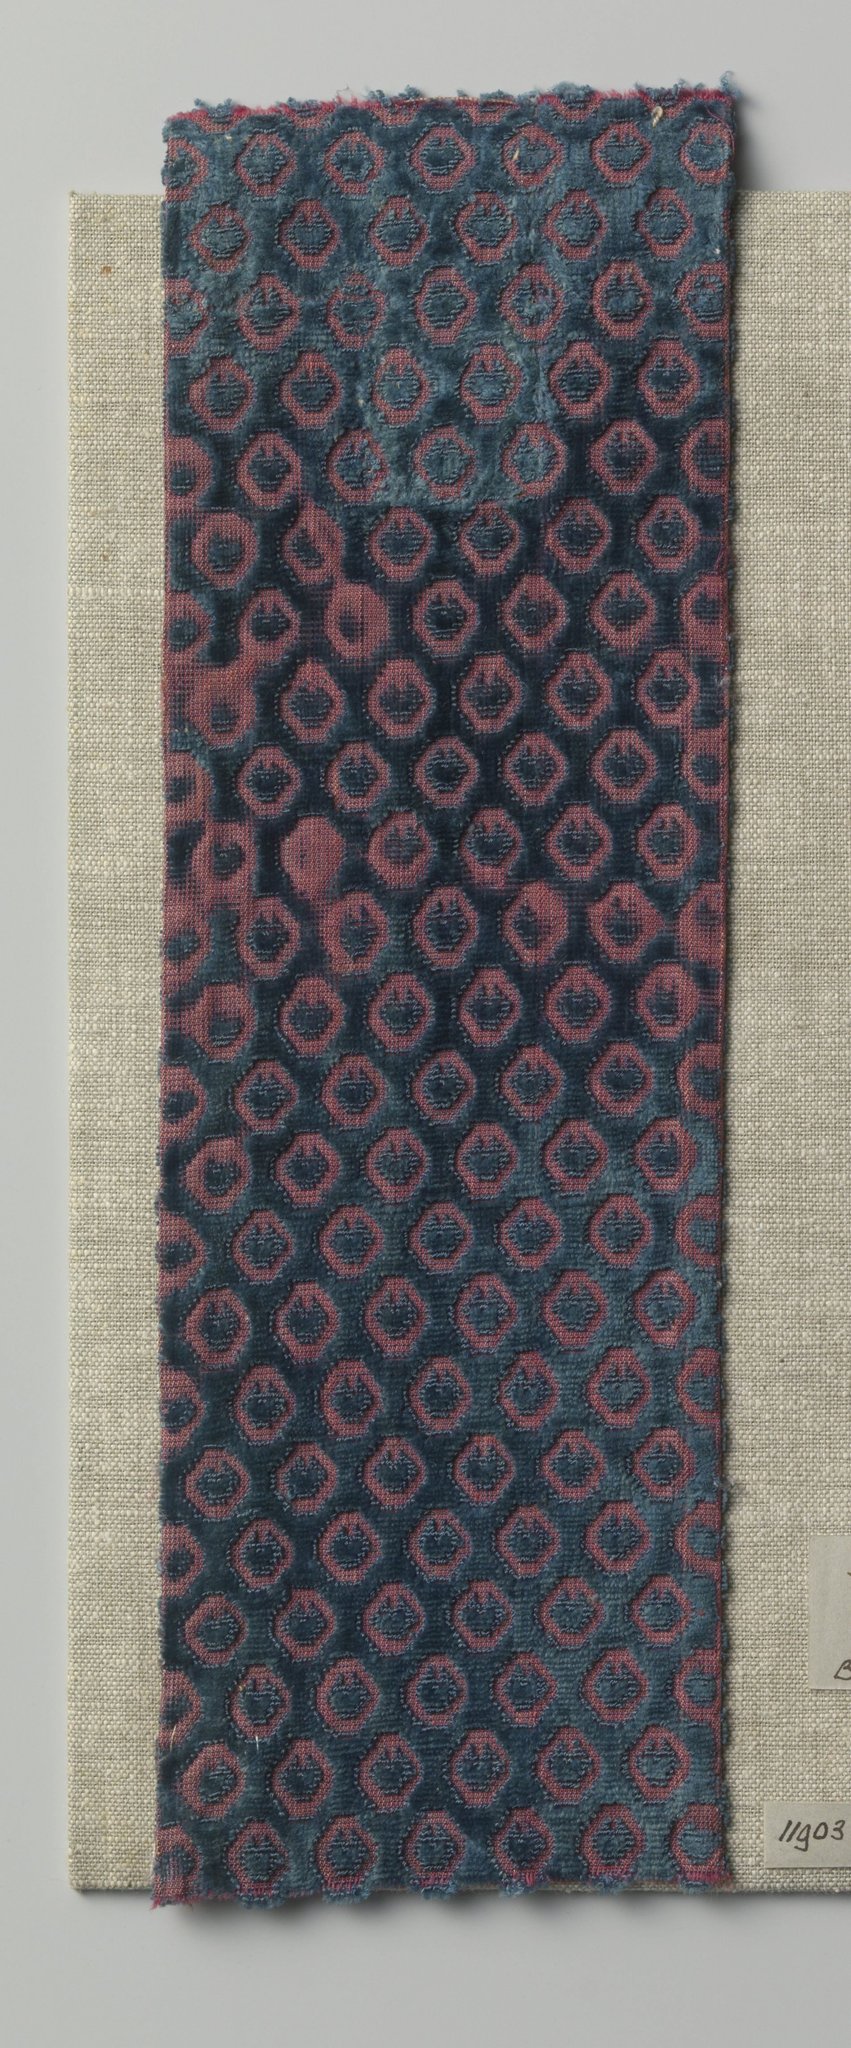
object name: zijdefluweel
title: Fragment blauw ciseléfluweel met rood fond waarop patroon van zeshoeken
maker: Anonymous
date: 1500-1599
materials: silk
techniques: velvet, weave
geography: italy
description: Fragment blauw zijden ciseléfluweel met uitsparingen met rood fond waarop patroon van zeshoeken.